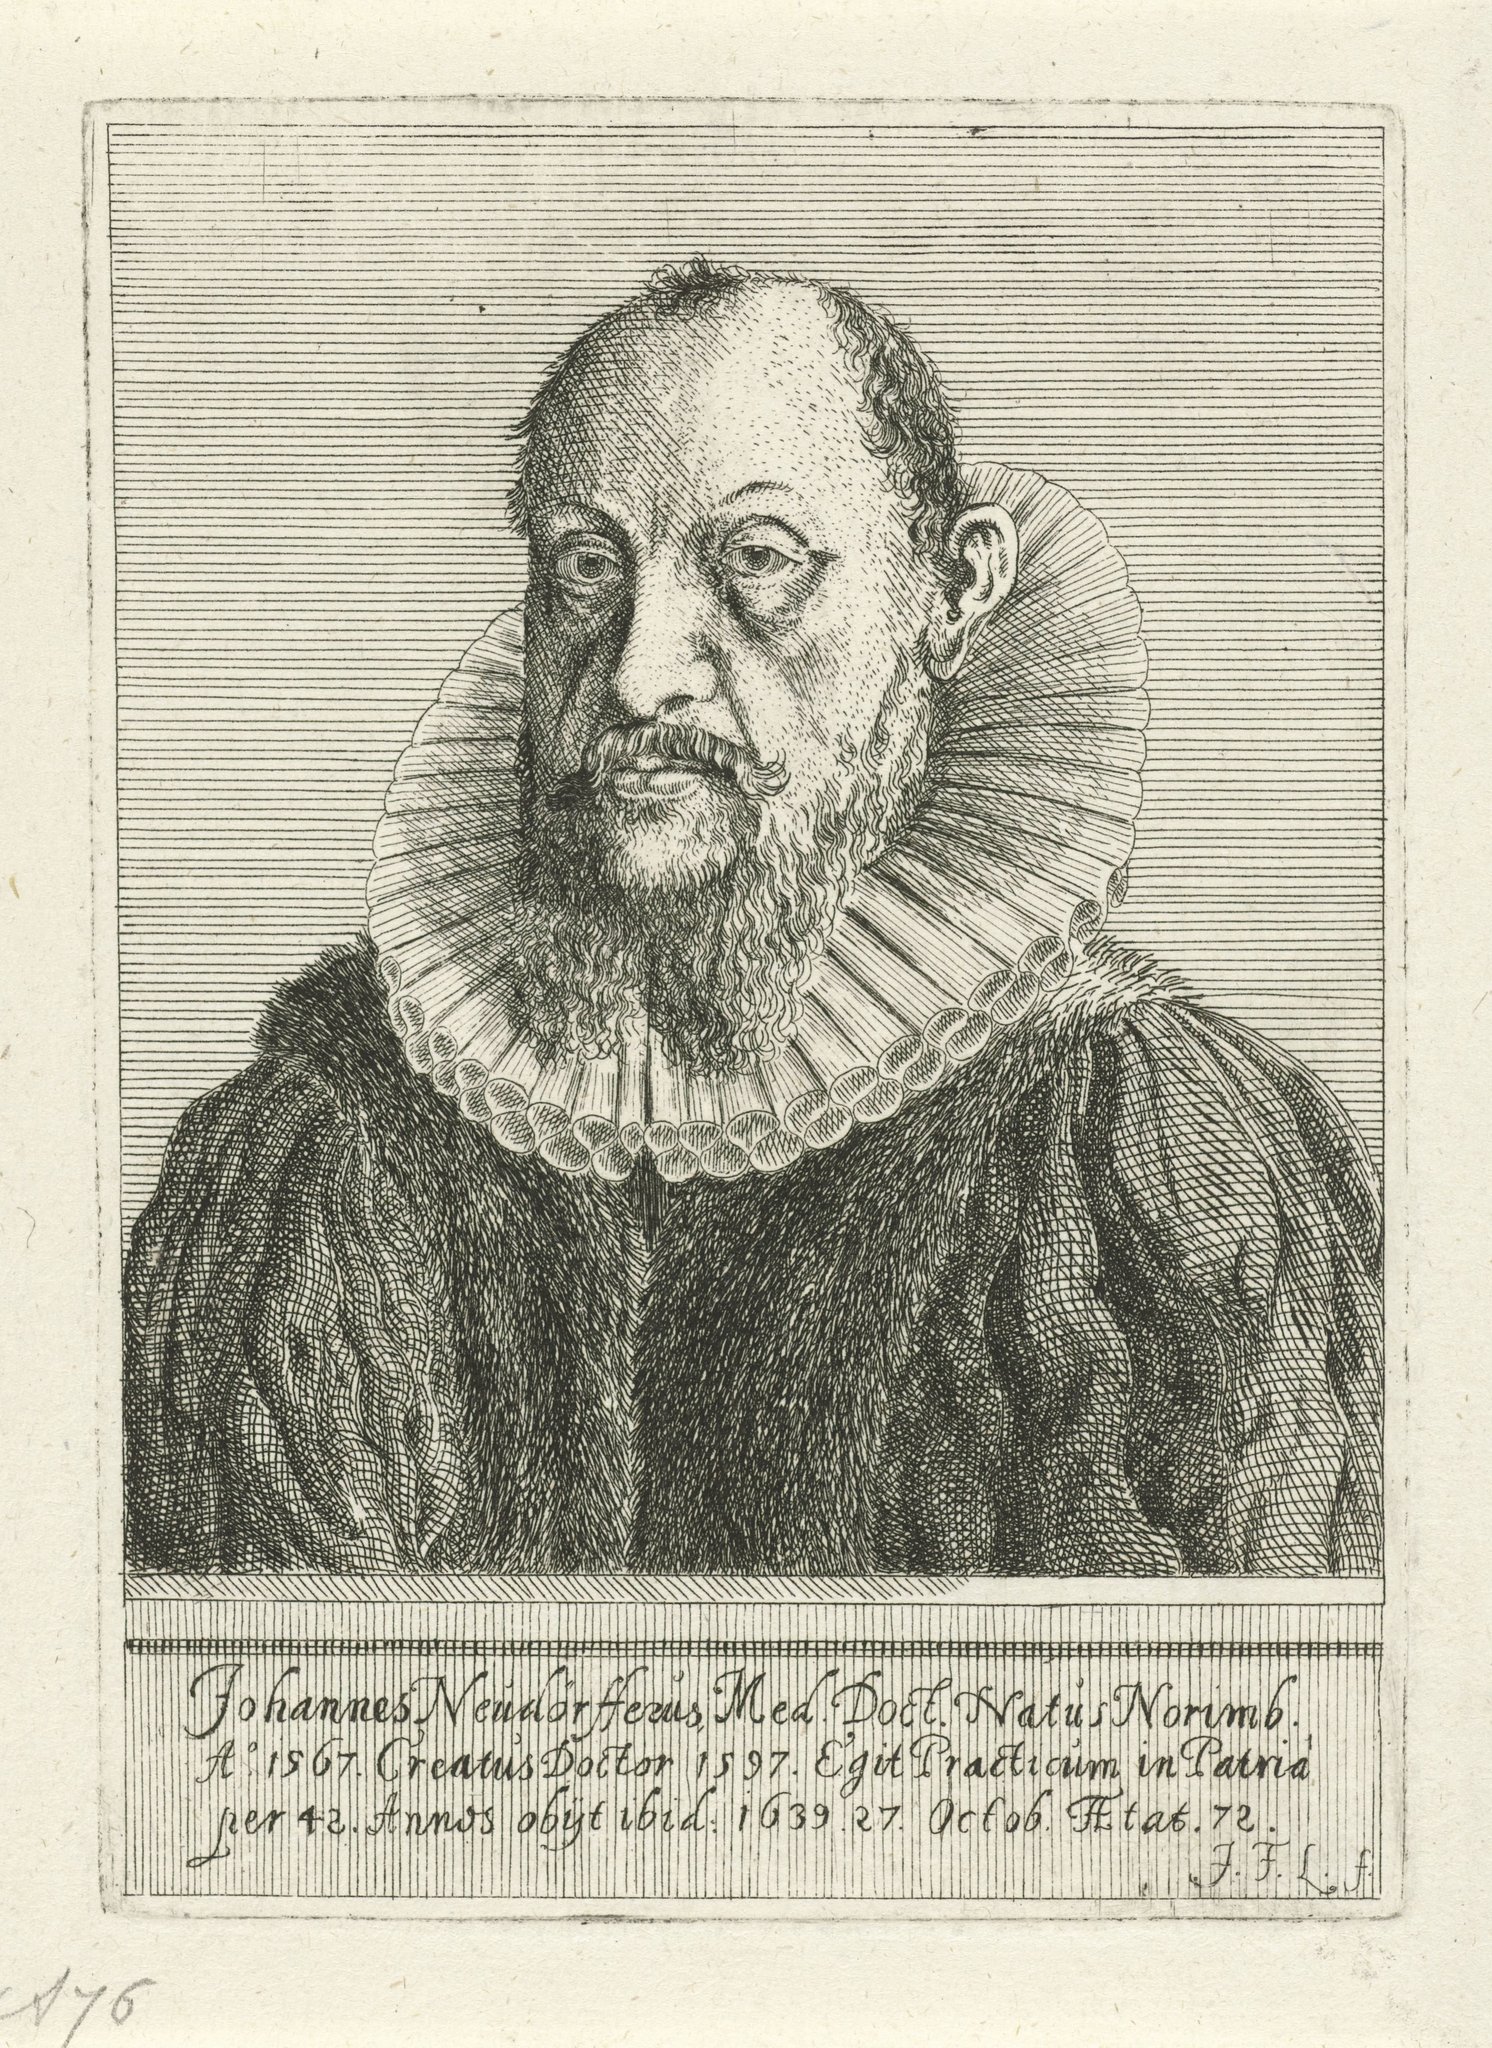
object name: print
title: Portret van Johannes Neudörffer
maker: johann friedrich leonard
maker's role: print maker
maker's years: 1633-1680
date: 1643-1680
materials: paper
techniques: engraving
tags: neurenberg, johannes neudörffer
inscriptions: collector's mark: Lugt 1337, collector's mark: Lugt 2228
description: Portret van Johannes Neudörffer, arts te Neurenberg.